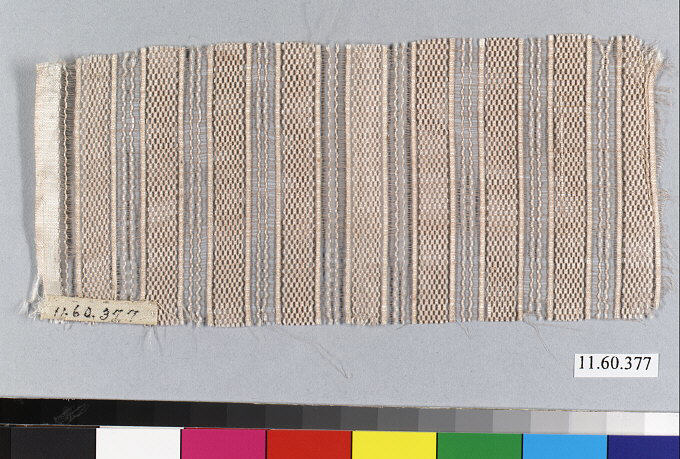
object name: fragment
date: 1801-1900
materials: silk